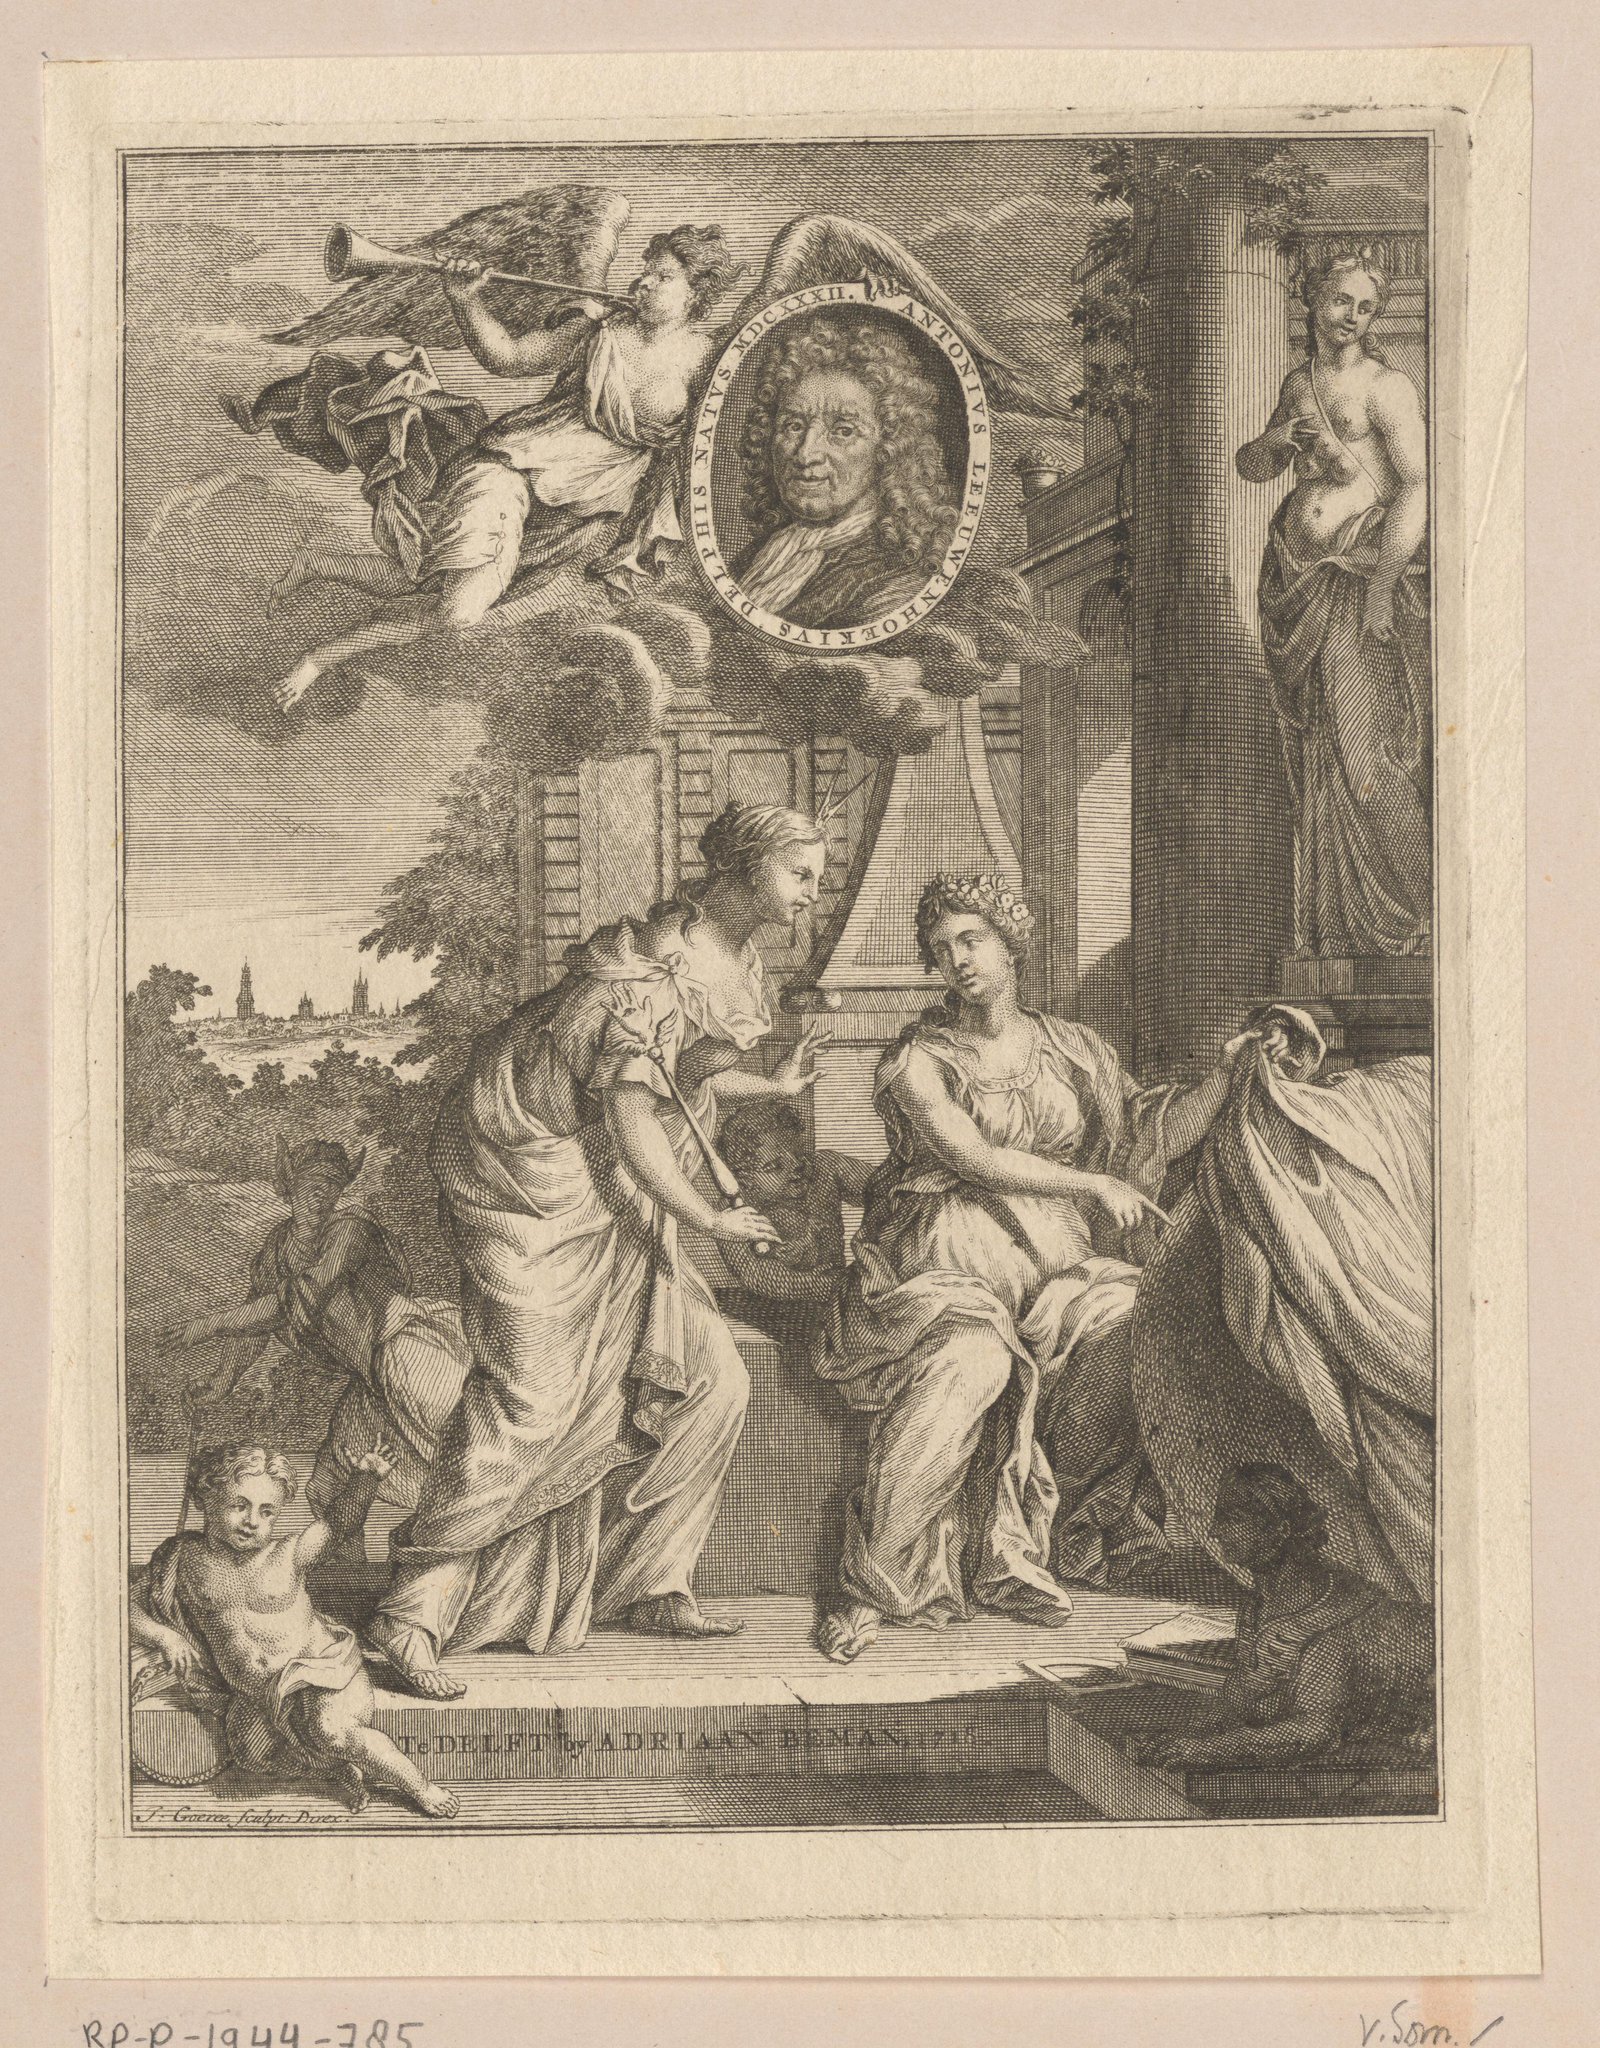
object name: book illustration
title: Allegorie met het portret van Anthony van Leeuwenhoek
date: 1718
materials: paper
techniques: etching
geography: delft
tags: delft, anthony van leeuwenhoek, city-view, and landscape with man-made constructions, column, pillar ~ architecture, ornament ~ medallion, historical persons, compasses, globe, midas given ass's ears: apollo gives midas ass's ears as punishment for preferring pan in the musical contest between apollo and pan (ovid, metamorphoses xi 174), angels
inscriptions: collector's mark: Lugt 2228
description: Een engel met een loftrompet houdt het portret van Van Leeuwenhoek in medaillon vast. Een vrouw met bloemenkrans wijst een andere vrouw met passer op haar hoofd (personificatie van de Landmeting of Aardrijkskunde) op een aardbol die half verscholen gaat onder een doek. Linksachter een geblinddoekte Midas met ezelsoren.